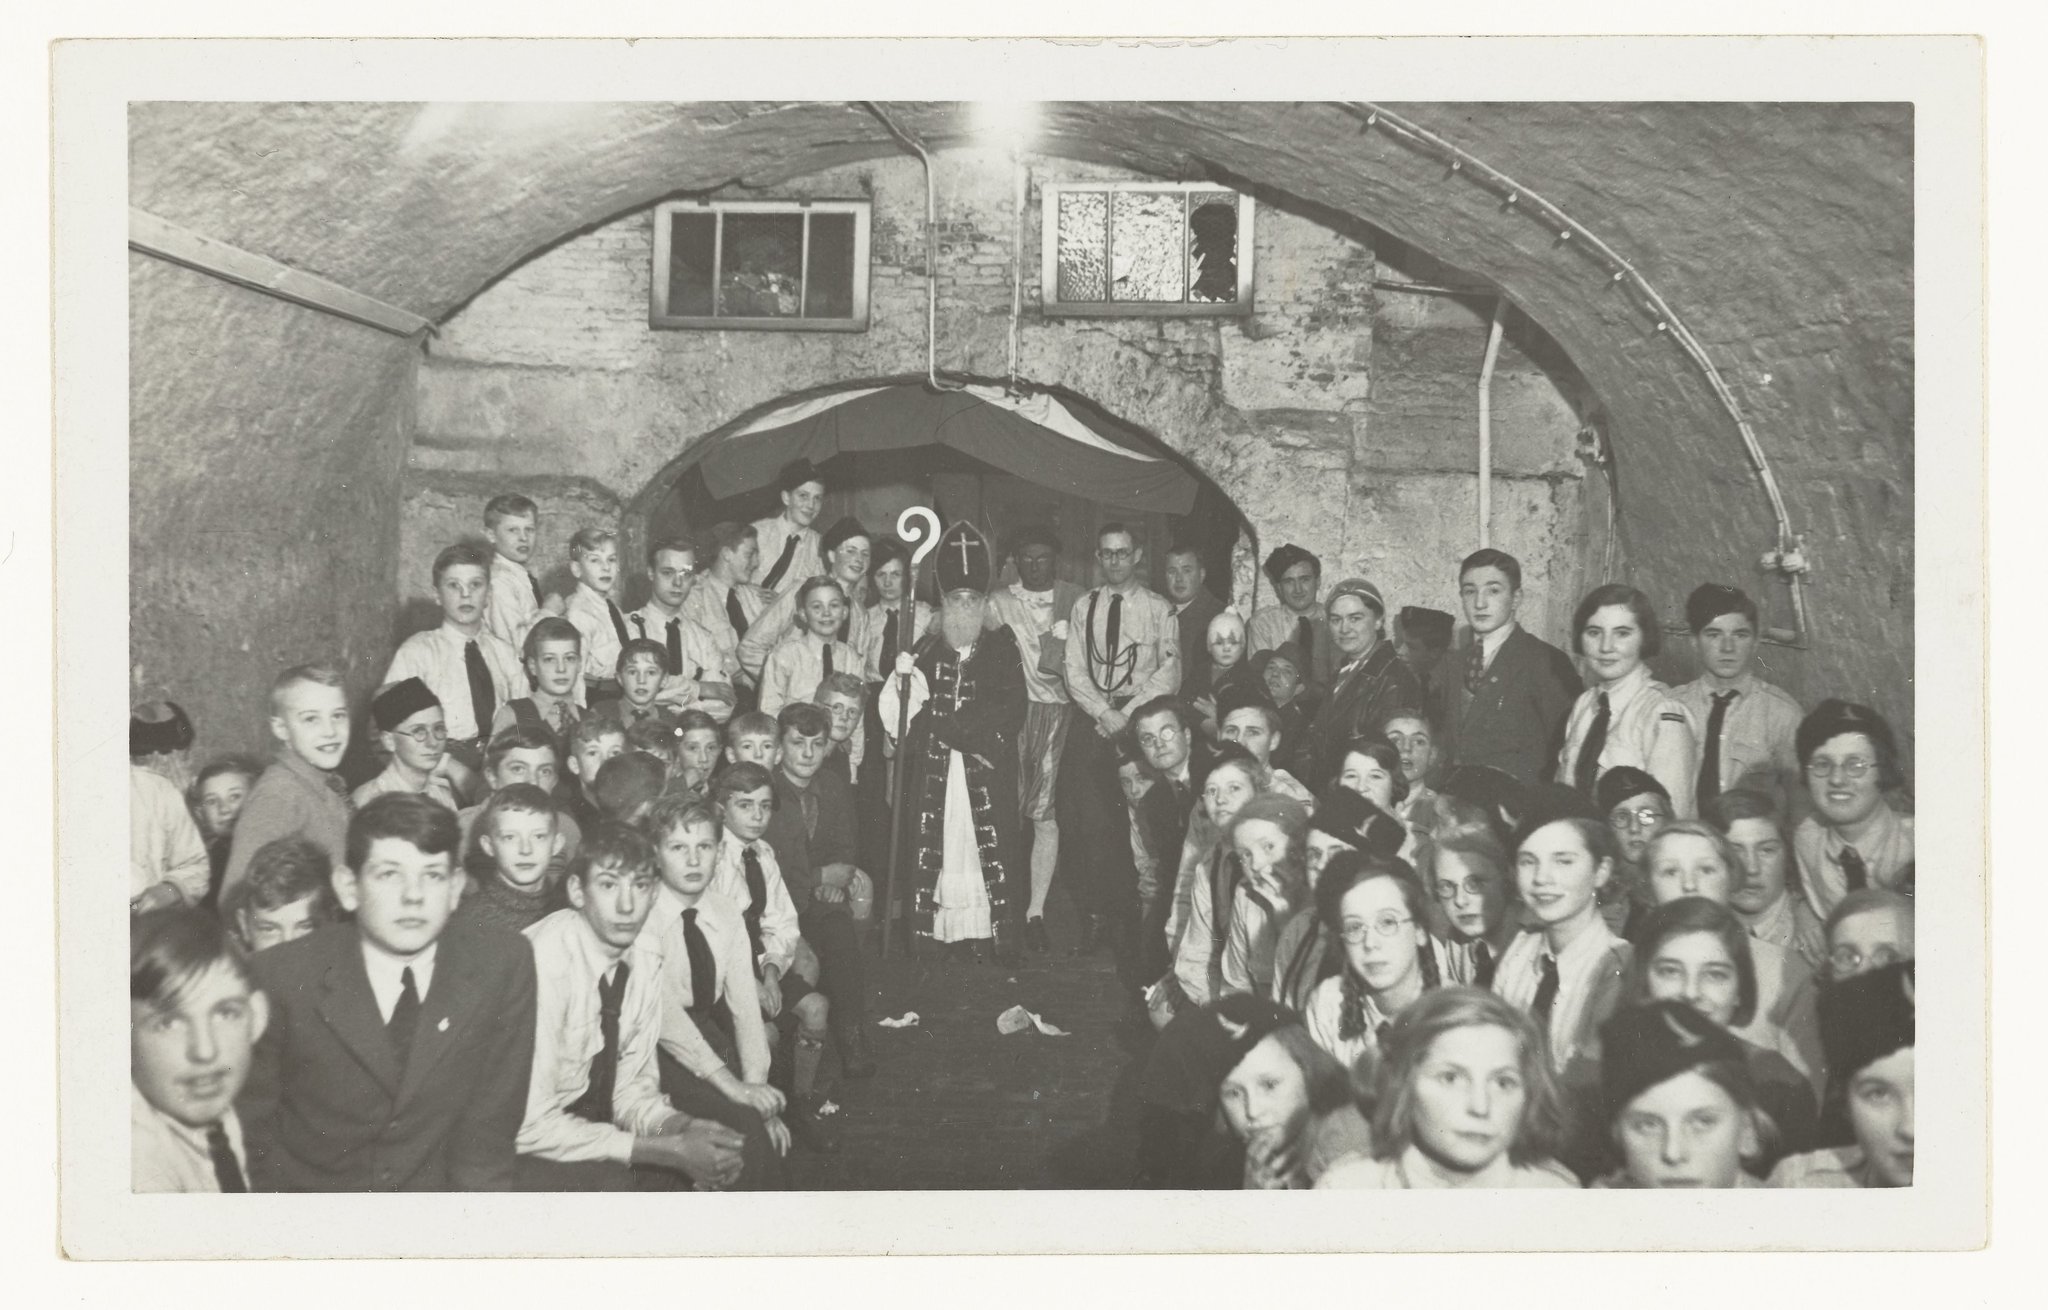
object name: photograph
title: Sinterklaasfeest van de Jeugdstorm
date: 1935-1940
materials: photographic support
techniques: gelatin silver print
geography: utrecht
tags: military celebrations, utrecht, saint nicholas day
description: Sinterklaasfeest voor leden van de Jeugdstorm. Sinterklaas en Zwarte Piet staan in het midden omringd door leden, de meesten in uniform. Het feest wordt gehouden in de Werfkelder van het "Kringhuis" van de Jeugdstorm in Utrecht.